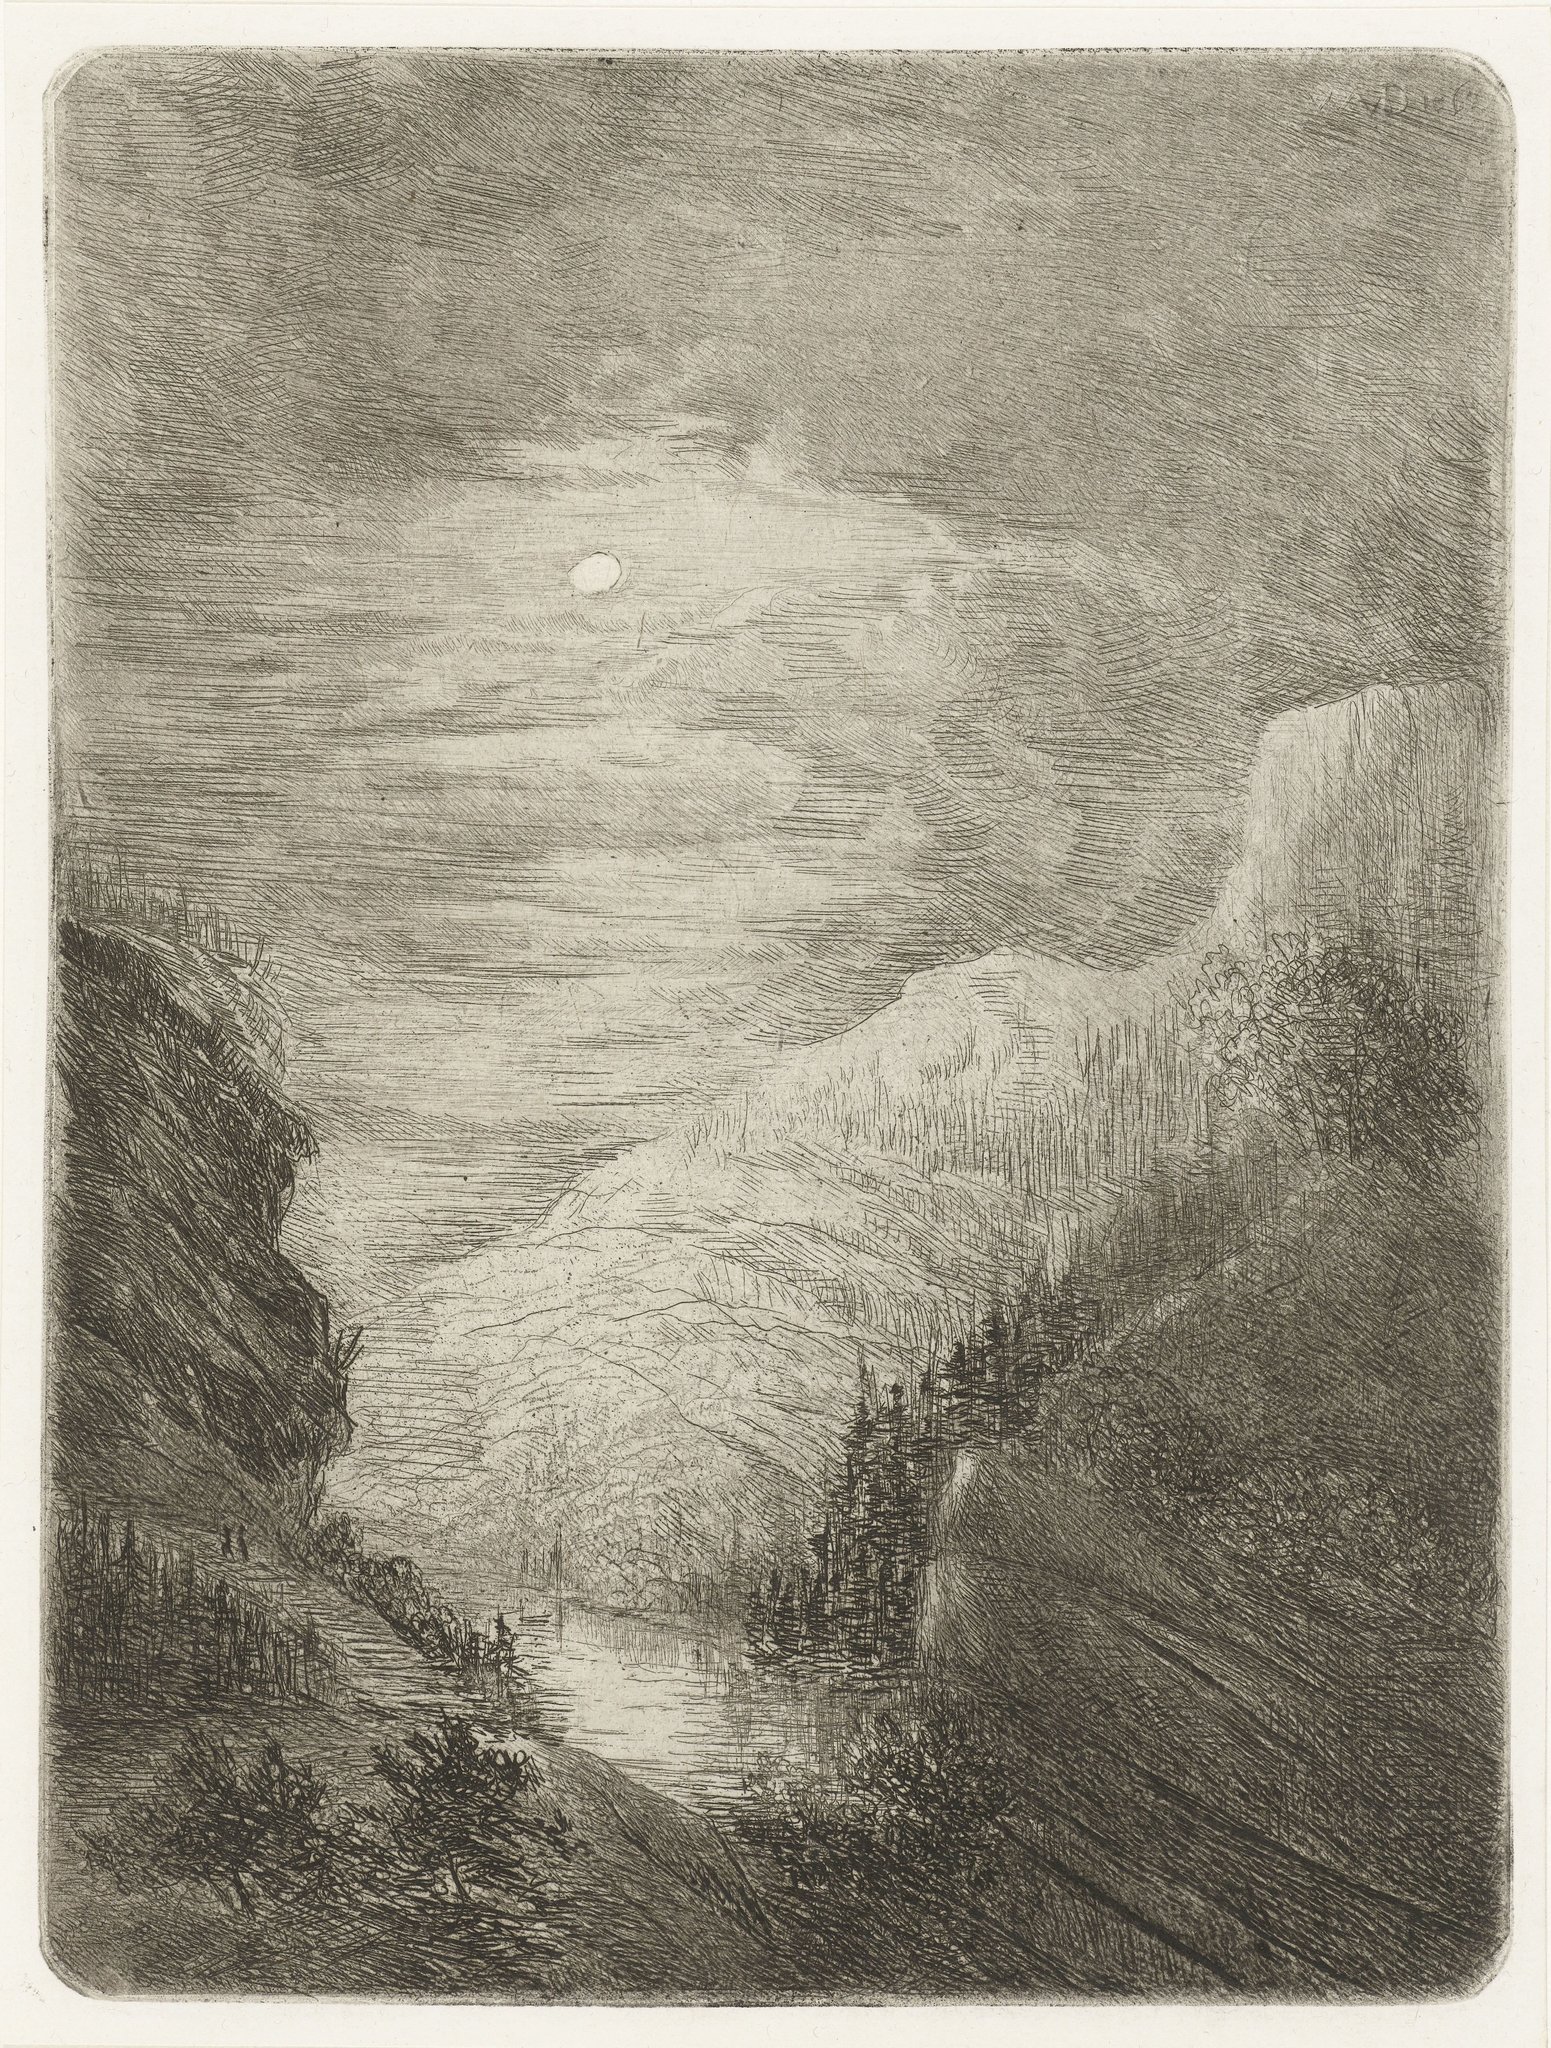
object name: print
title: Berglandschap met rivier in maanlicht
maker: willem matthias jan van dielen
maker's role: print maker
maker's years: 1805-1867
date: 1867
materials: paper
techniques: drypoint, etching, intaglio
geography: netherlands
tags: river, moonlight, mountains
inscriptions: collector's mark: Lugt 2228